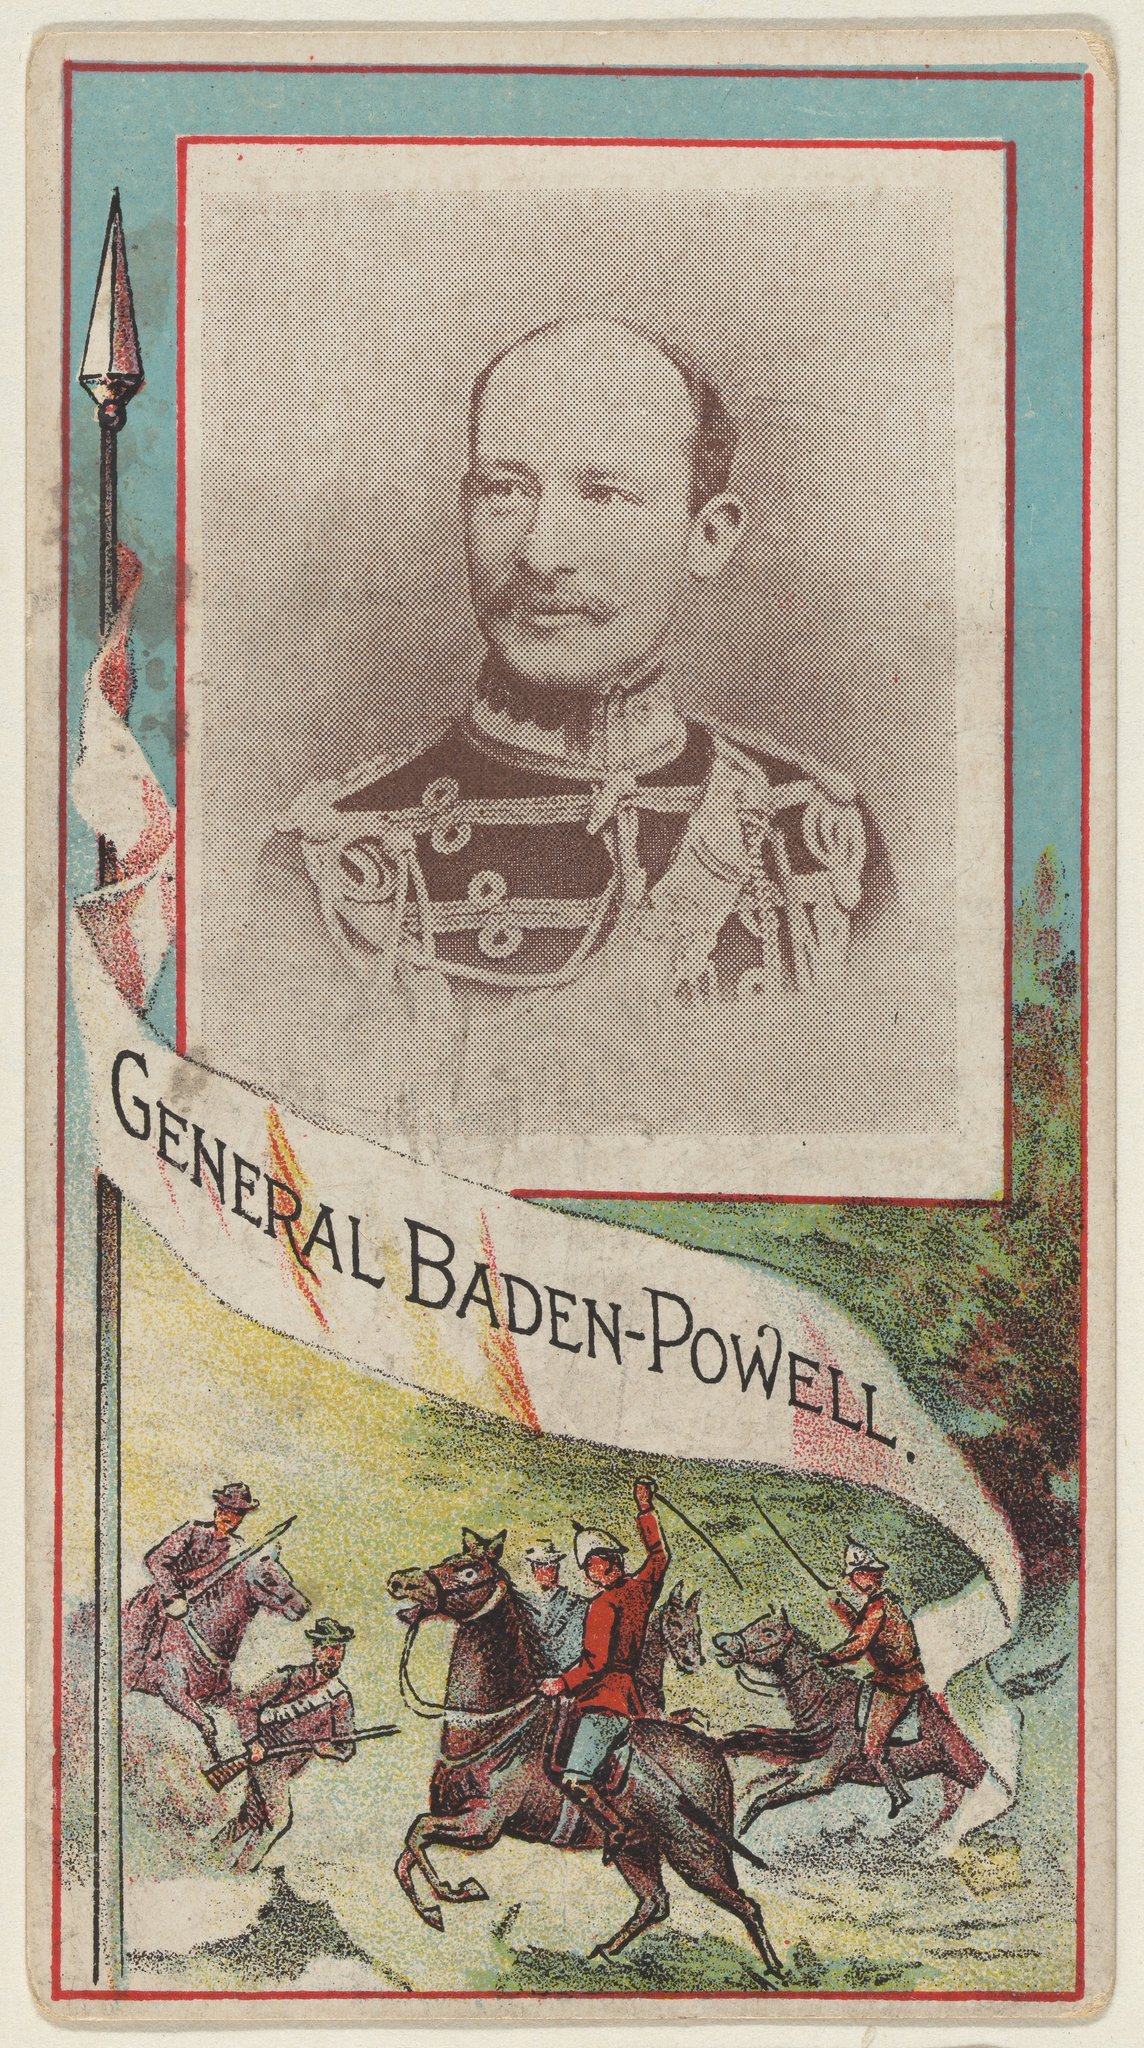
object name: print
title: General Baden-Powell, from the "Generals" series (T64), issued by D.H. McAlpin & Co. Tobacco Company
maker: d.h. mcalpin & co. tobacco company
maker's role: publisher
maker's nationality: american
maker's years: 1857-1901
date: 1901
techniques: color lithograph